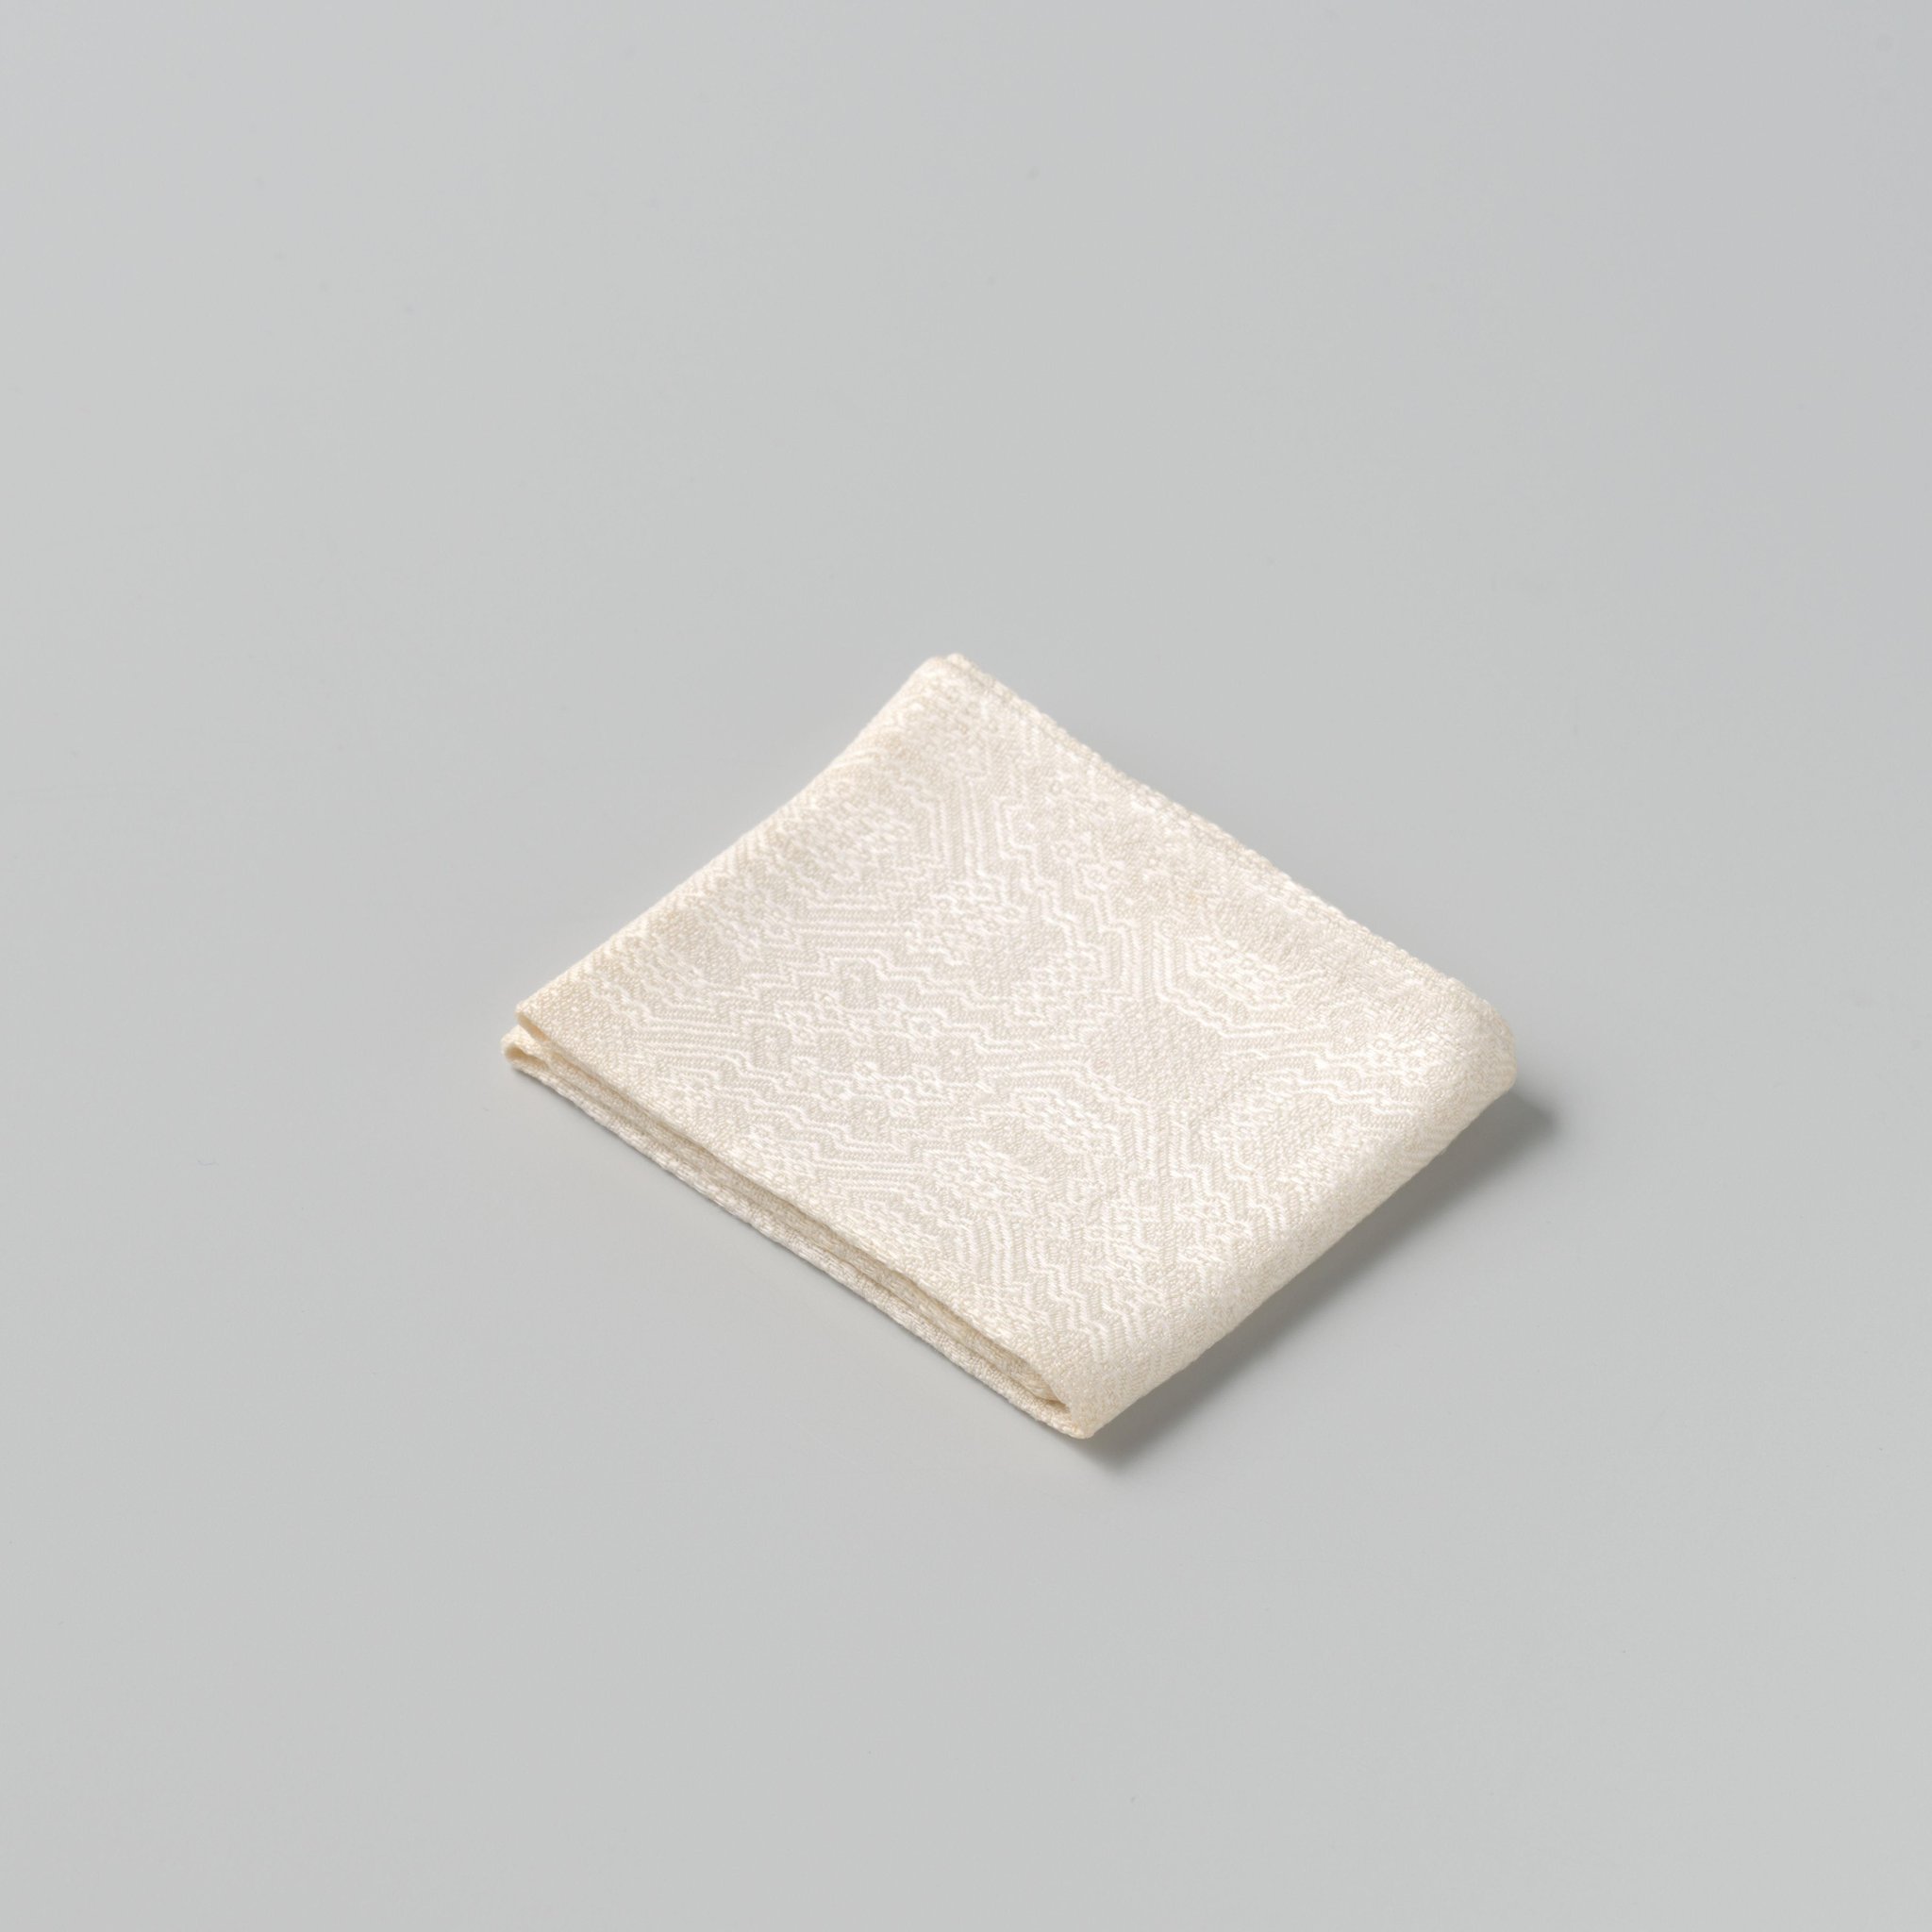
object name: miniature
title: Handdoek, damastweefsel met een pellenpatroon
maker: Anonymous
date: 1600-1699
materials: linen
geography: netherlands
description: Handdoek, damastweefsel met pellenpatroon, geknipt uit een groter stuk linnen, niet omgezoomd.